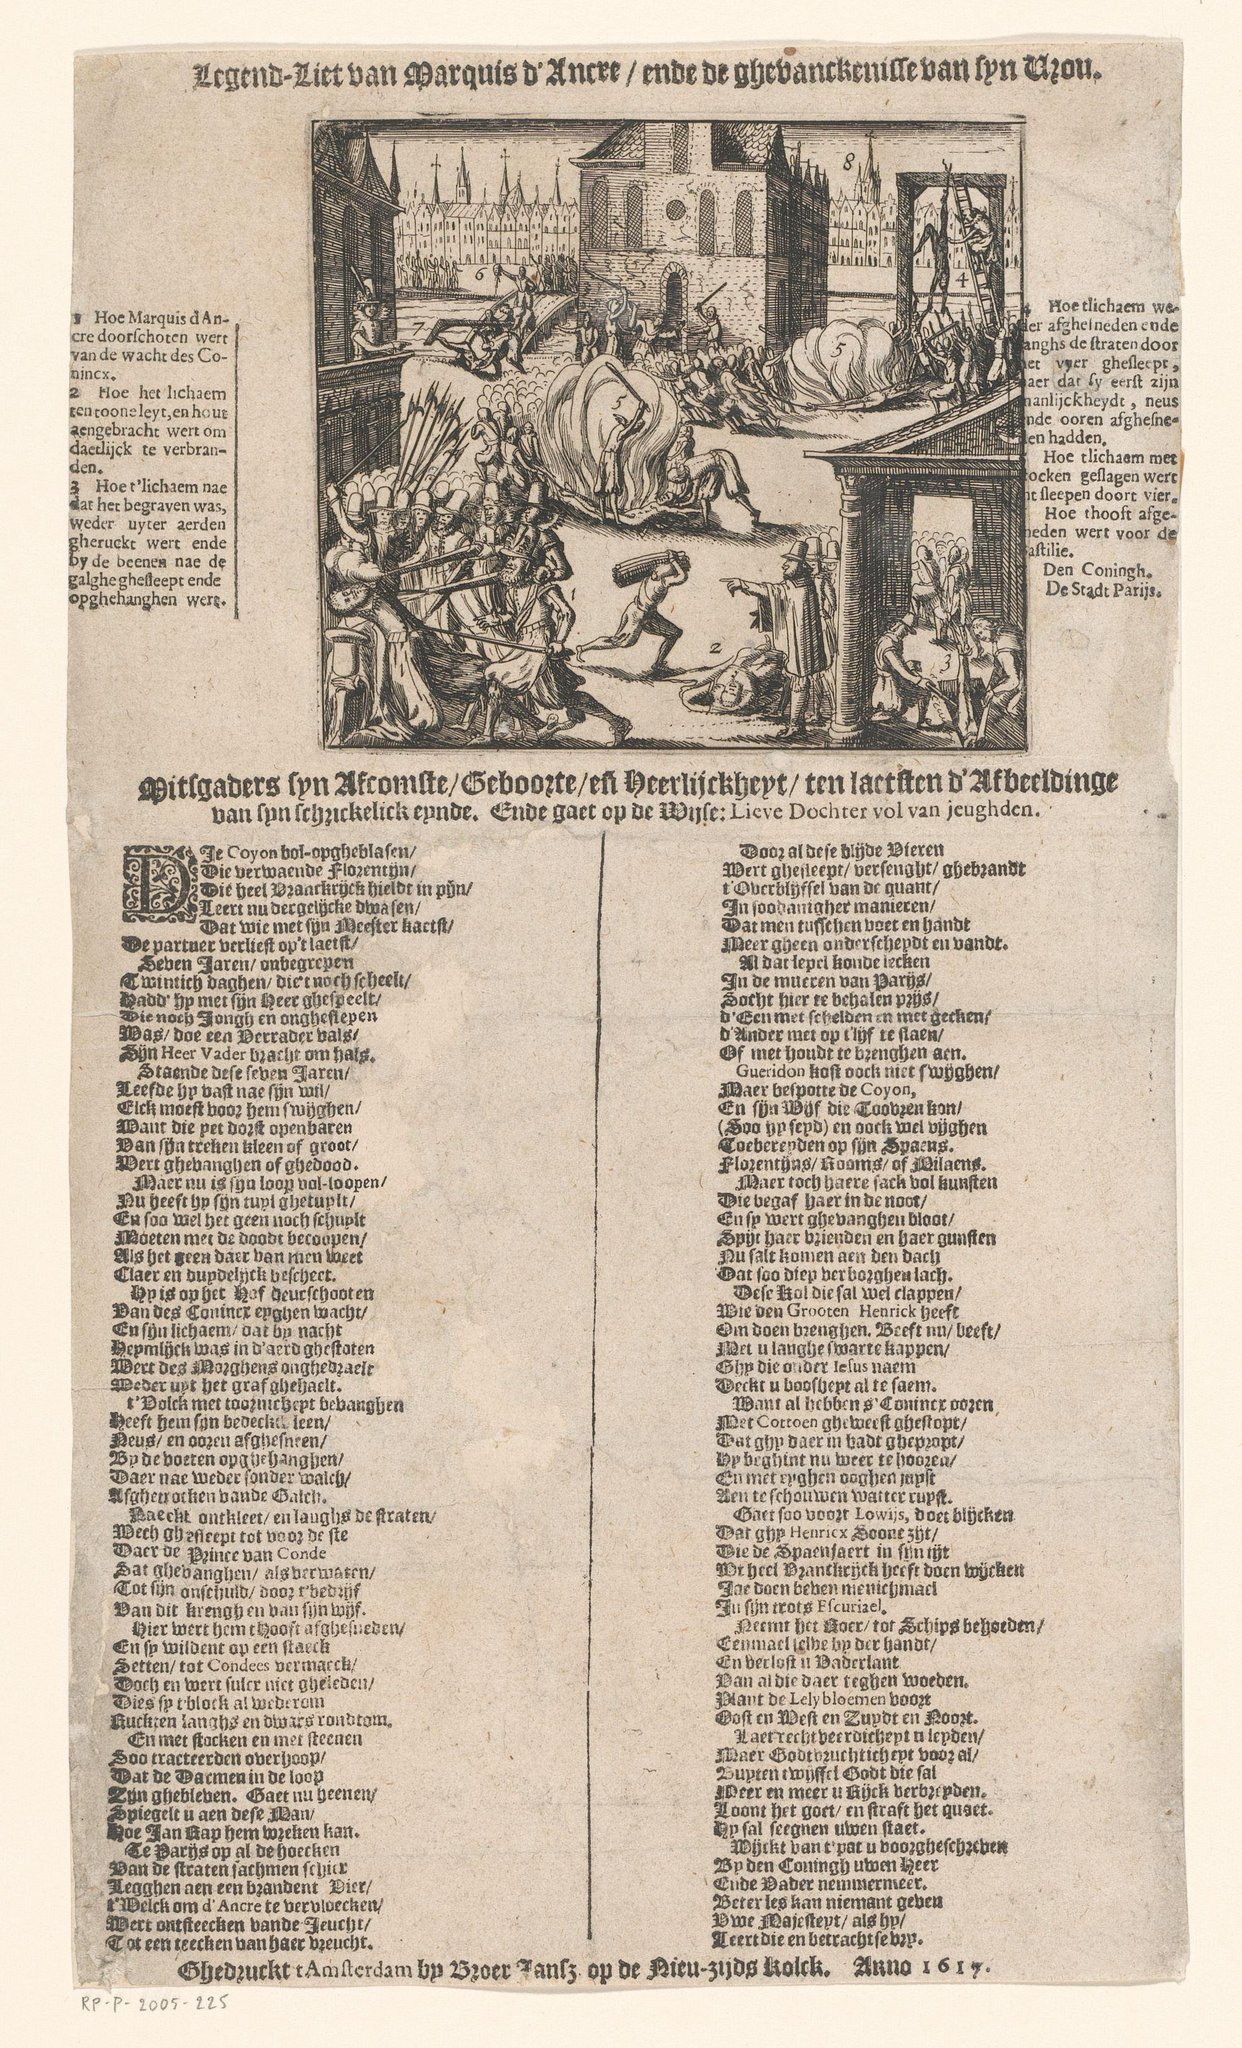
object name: print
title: Legend-Liet van Marquis d'Ancre / ende de ghevanckenisse syn Vrou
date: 1617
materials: paper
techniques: etching, letterpress printing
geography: amsterdam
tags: vocal popular music, newspaper, news-sheet, paris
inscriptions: title: ‘Legend-Liet van Marquis d'Ancee / ende ghevanckenisse van syn Vrou’, collector's mark: Lugt 2228, address: ‘Ghedruckt t Amsterdam by Broer Jansz. op de Nieu-zijds kolck. Anno 1617’, date: ‘Anno 1617’, collector's mark: Lugt 2760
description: De moordaanslag op de Italiaanse staatsman Concino Concini op 24 april 1617 in Parijs. Ets met legenda waaronder lied in twee kolommen in boekdruk (op de wijs van 'Lieve Dochter vol van jeughden).